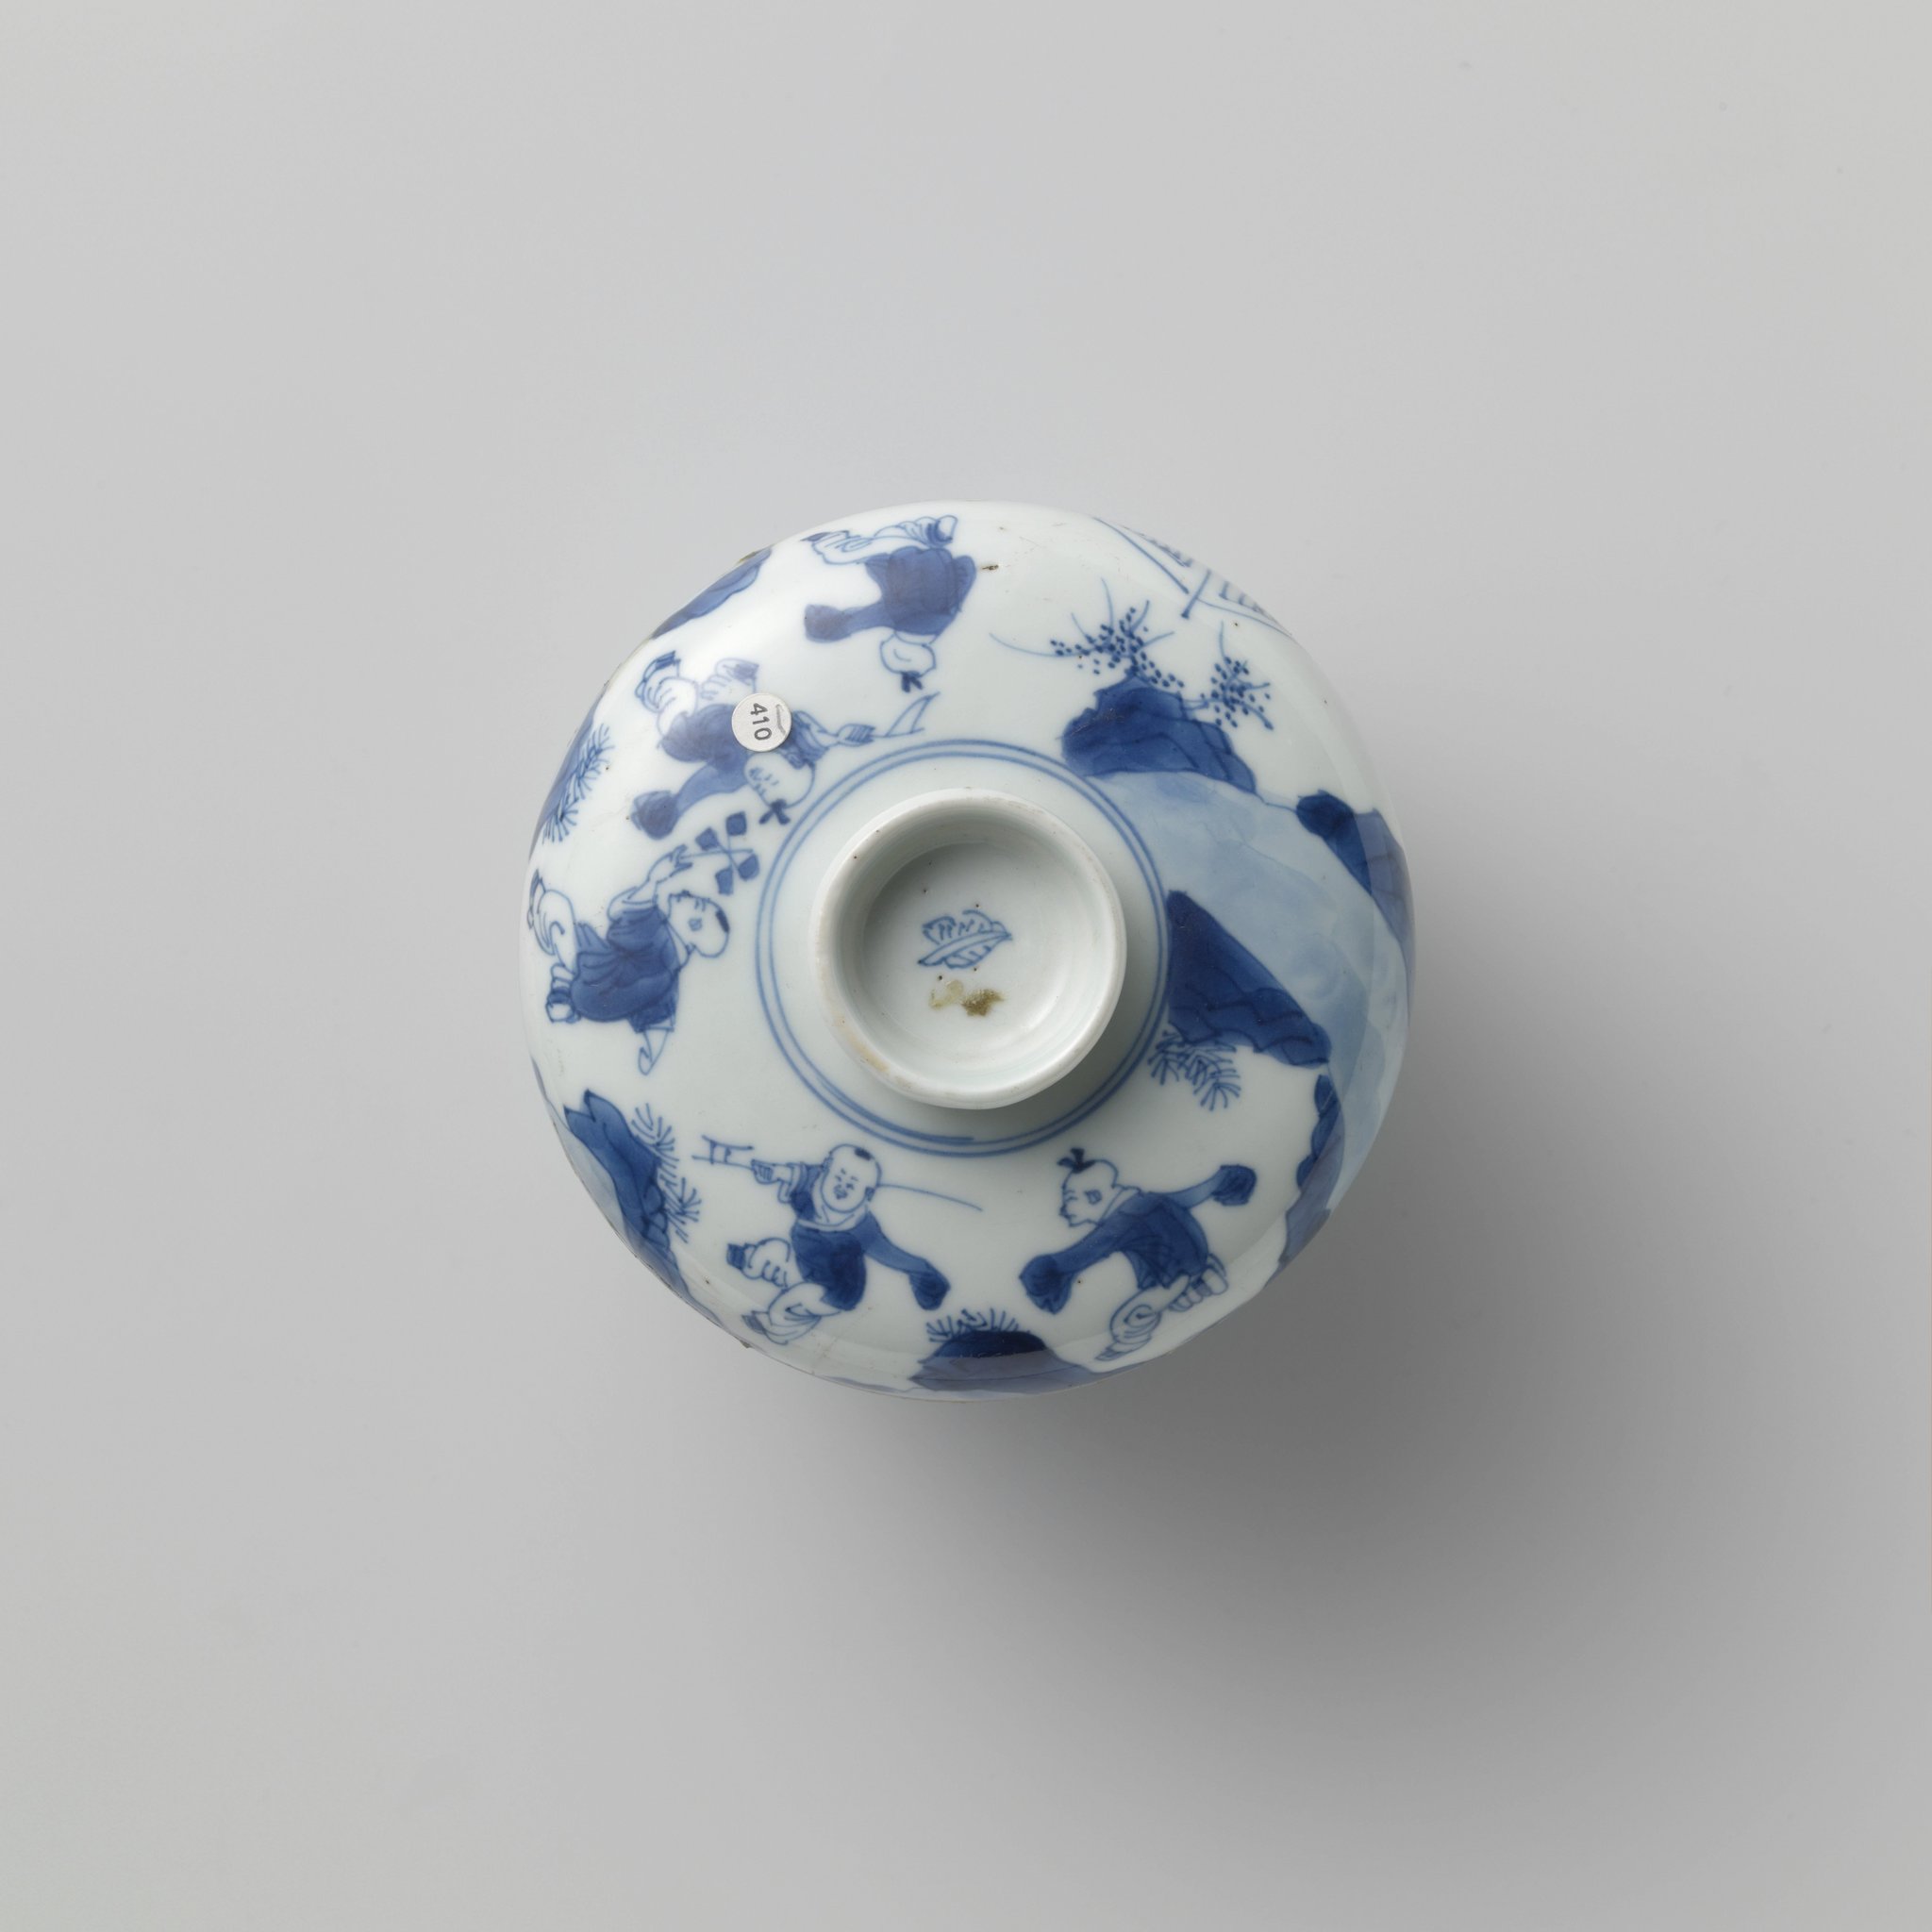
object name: covered jar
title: Covered jar with three women in a garden and playing boys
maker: Anonymous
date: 1680-1720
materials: cobalt, glaze, paint, porcelain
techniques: firing, turning, vitrification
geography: china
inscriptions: mark: ‘大 明 成 化 年 製’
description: Deksel met ringvormige knop van dekselpot van porselein, beschilderd in onderglazuur blauw. Op de deksel met vijf spelende jongens in een landschap met rotsen en planten afgebeld, in de ringvormige knop een artemisiablad. Blauw-wit.